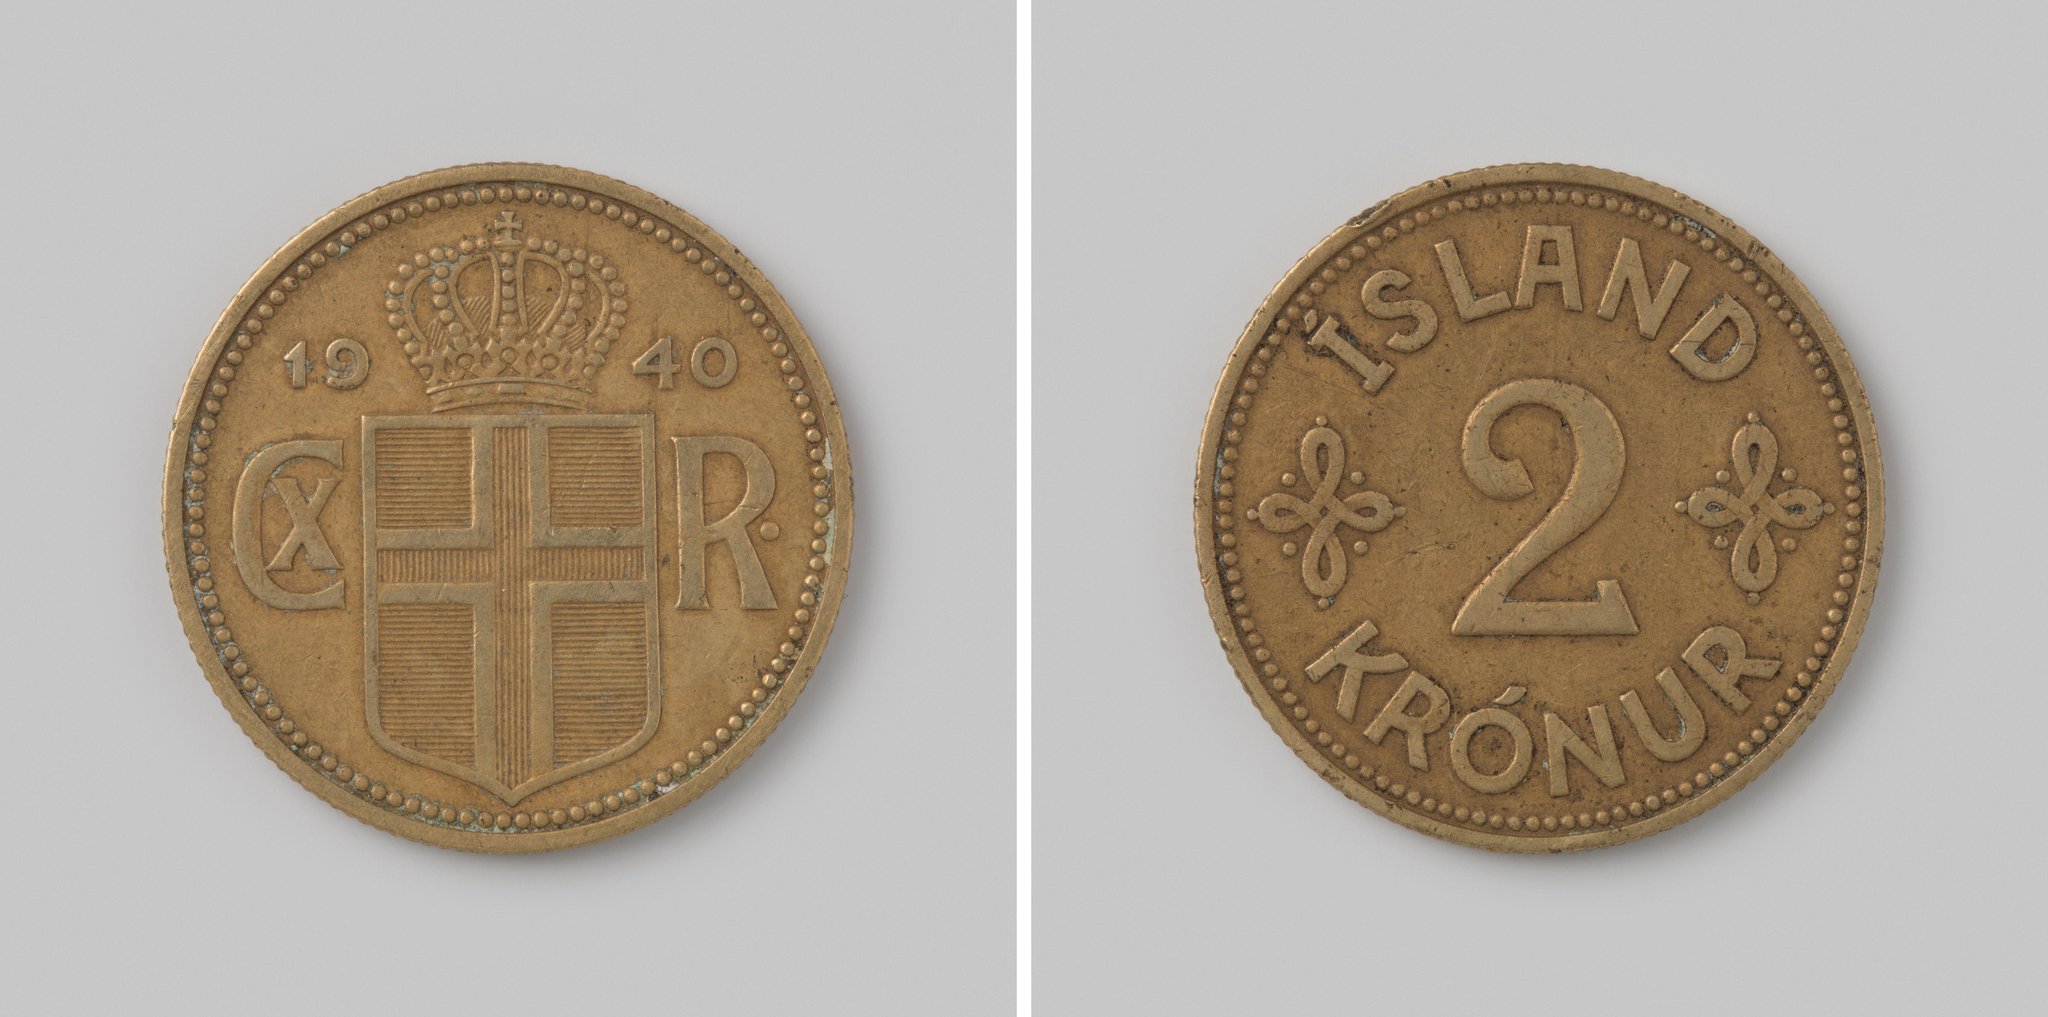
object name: coin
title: IJsland, Christiaan X, 2 kronur, 1940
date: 1940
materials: bronze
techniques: striking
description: Aluminium-bronzen munt. Voorzijde: tussen naams-aanduiding van de koning, waarboven jaartal, gekroond wapenschild. Keerzijde: tussen versiering waarde-aanduiding. Lands-aanduiding bovenaan in omschrift. Kartelrand.